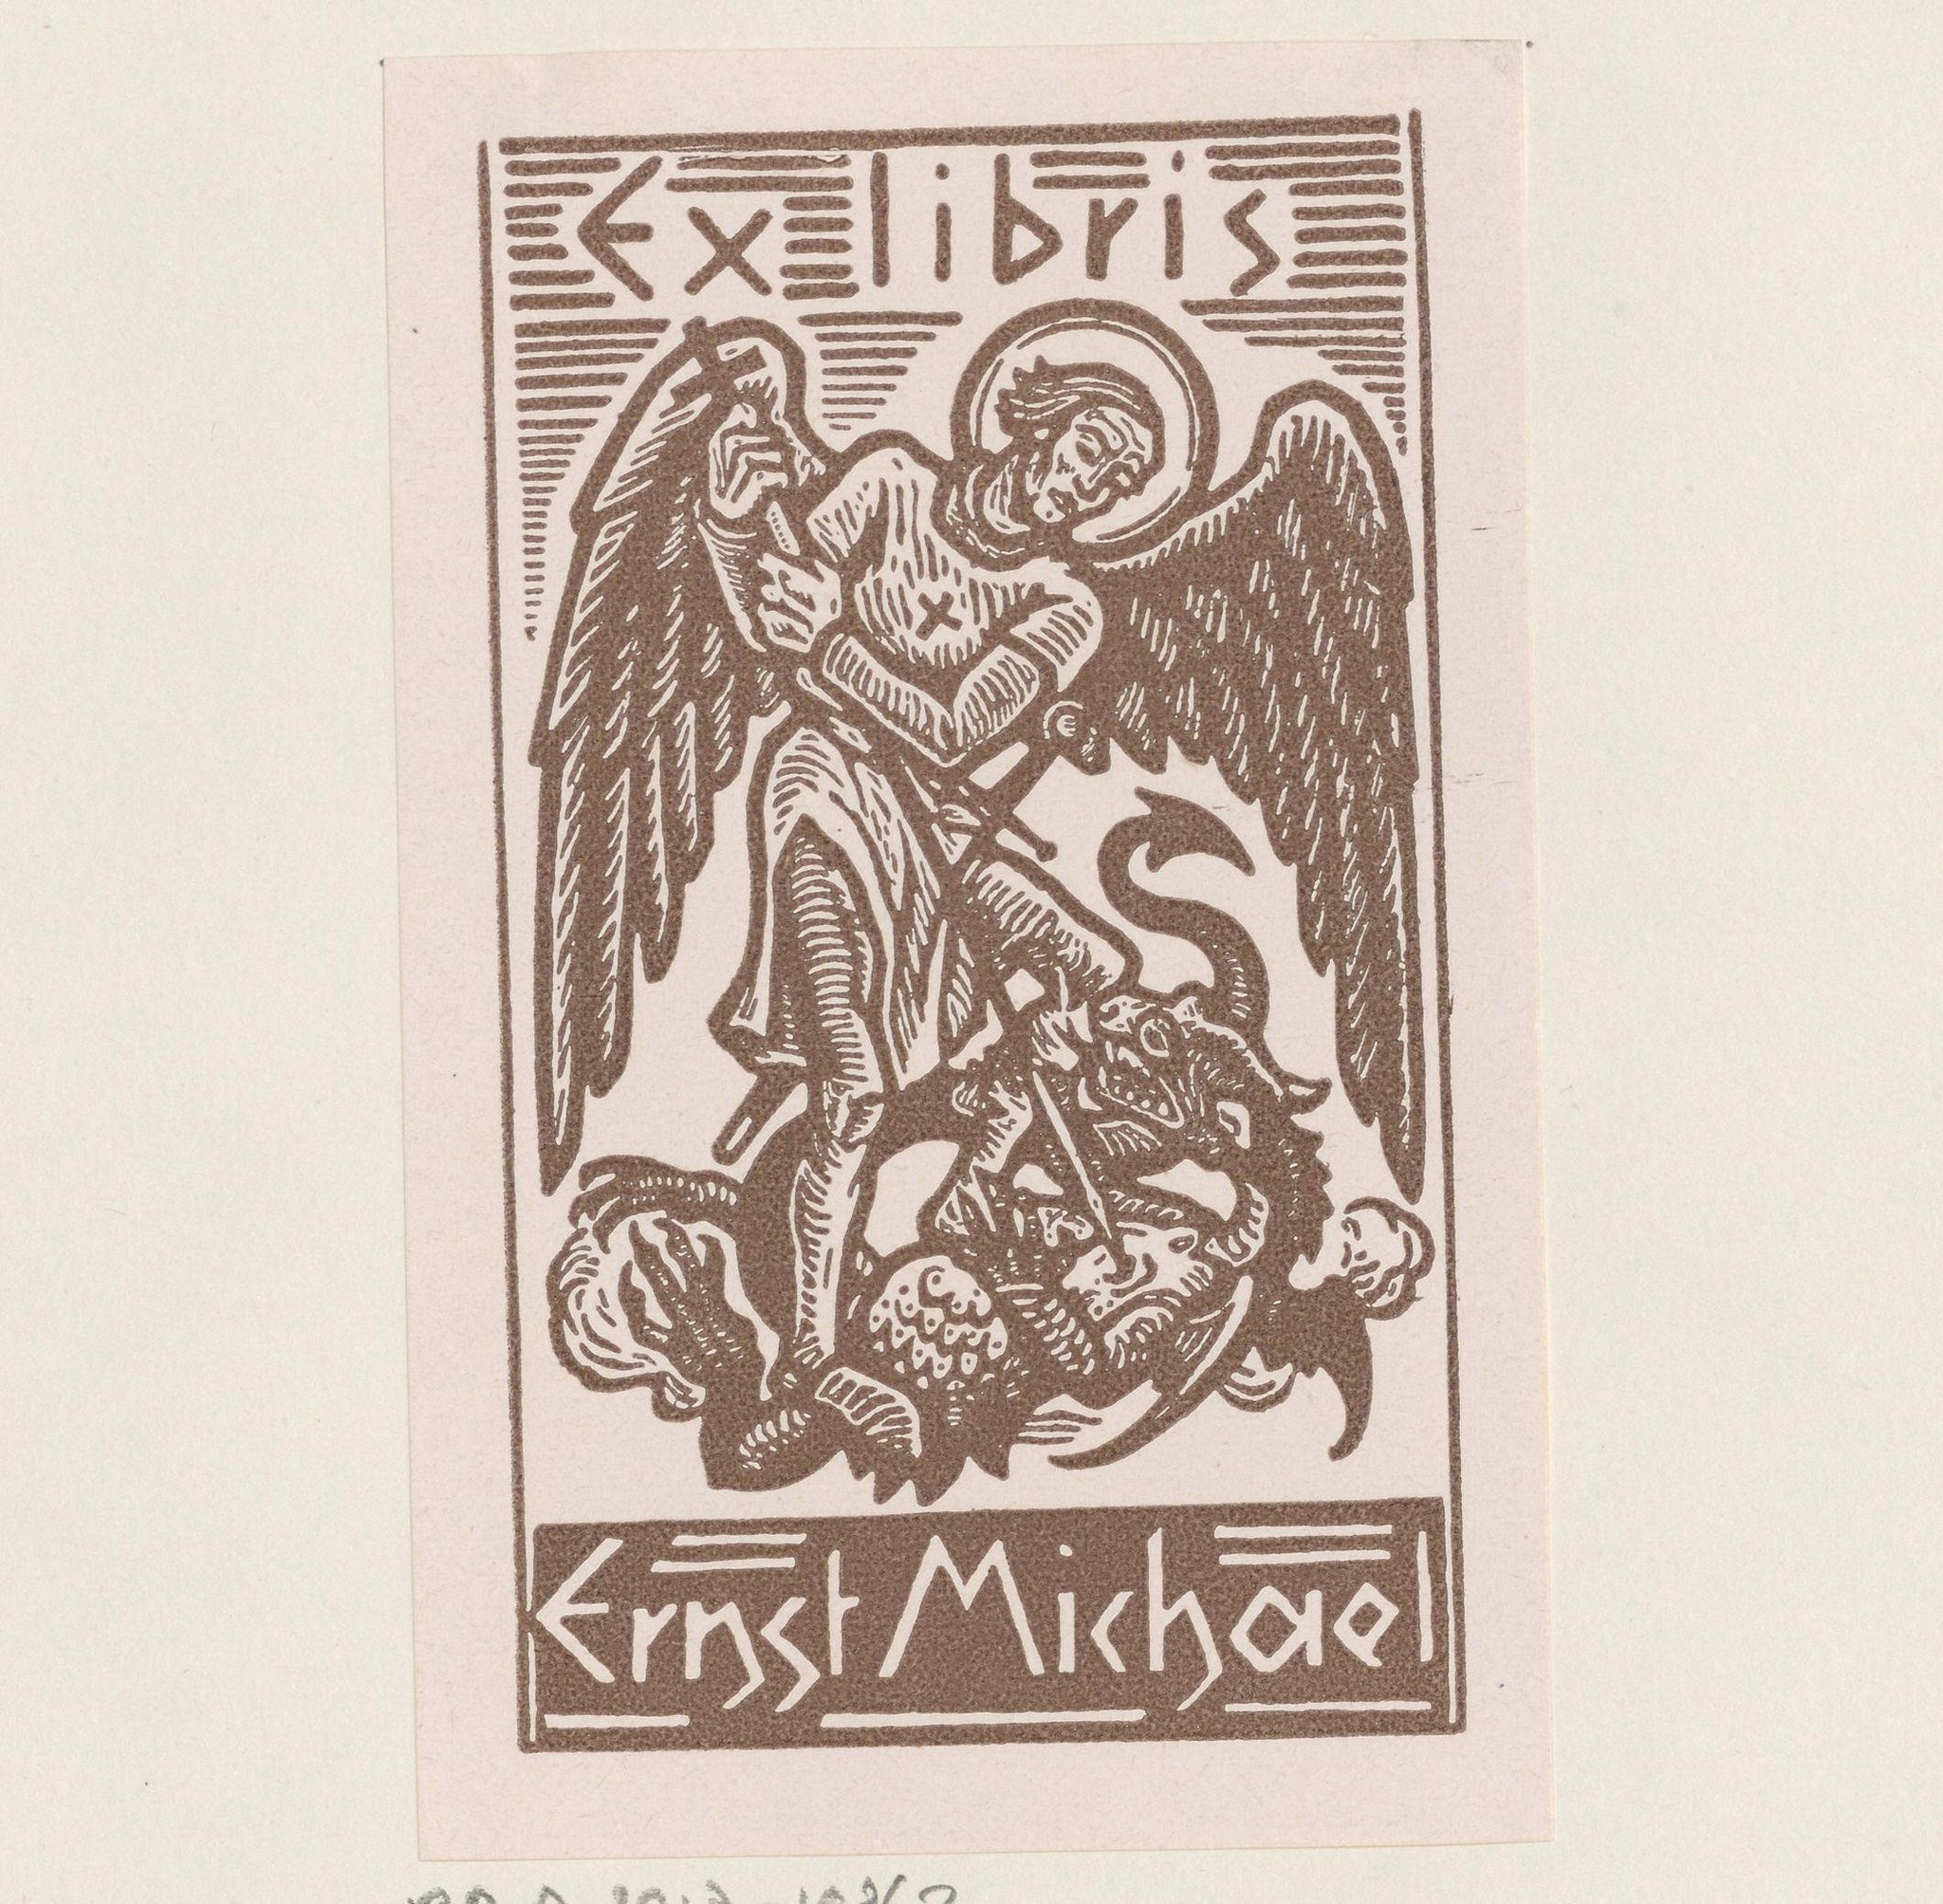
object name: bookplate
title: Ex libris van Ernst Michael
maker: Anonymous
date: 1900-1999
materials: paper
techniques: printing block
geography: germany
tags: the archangel michael fighting the dragon (devil, satan)